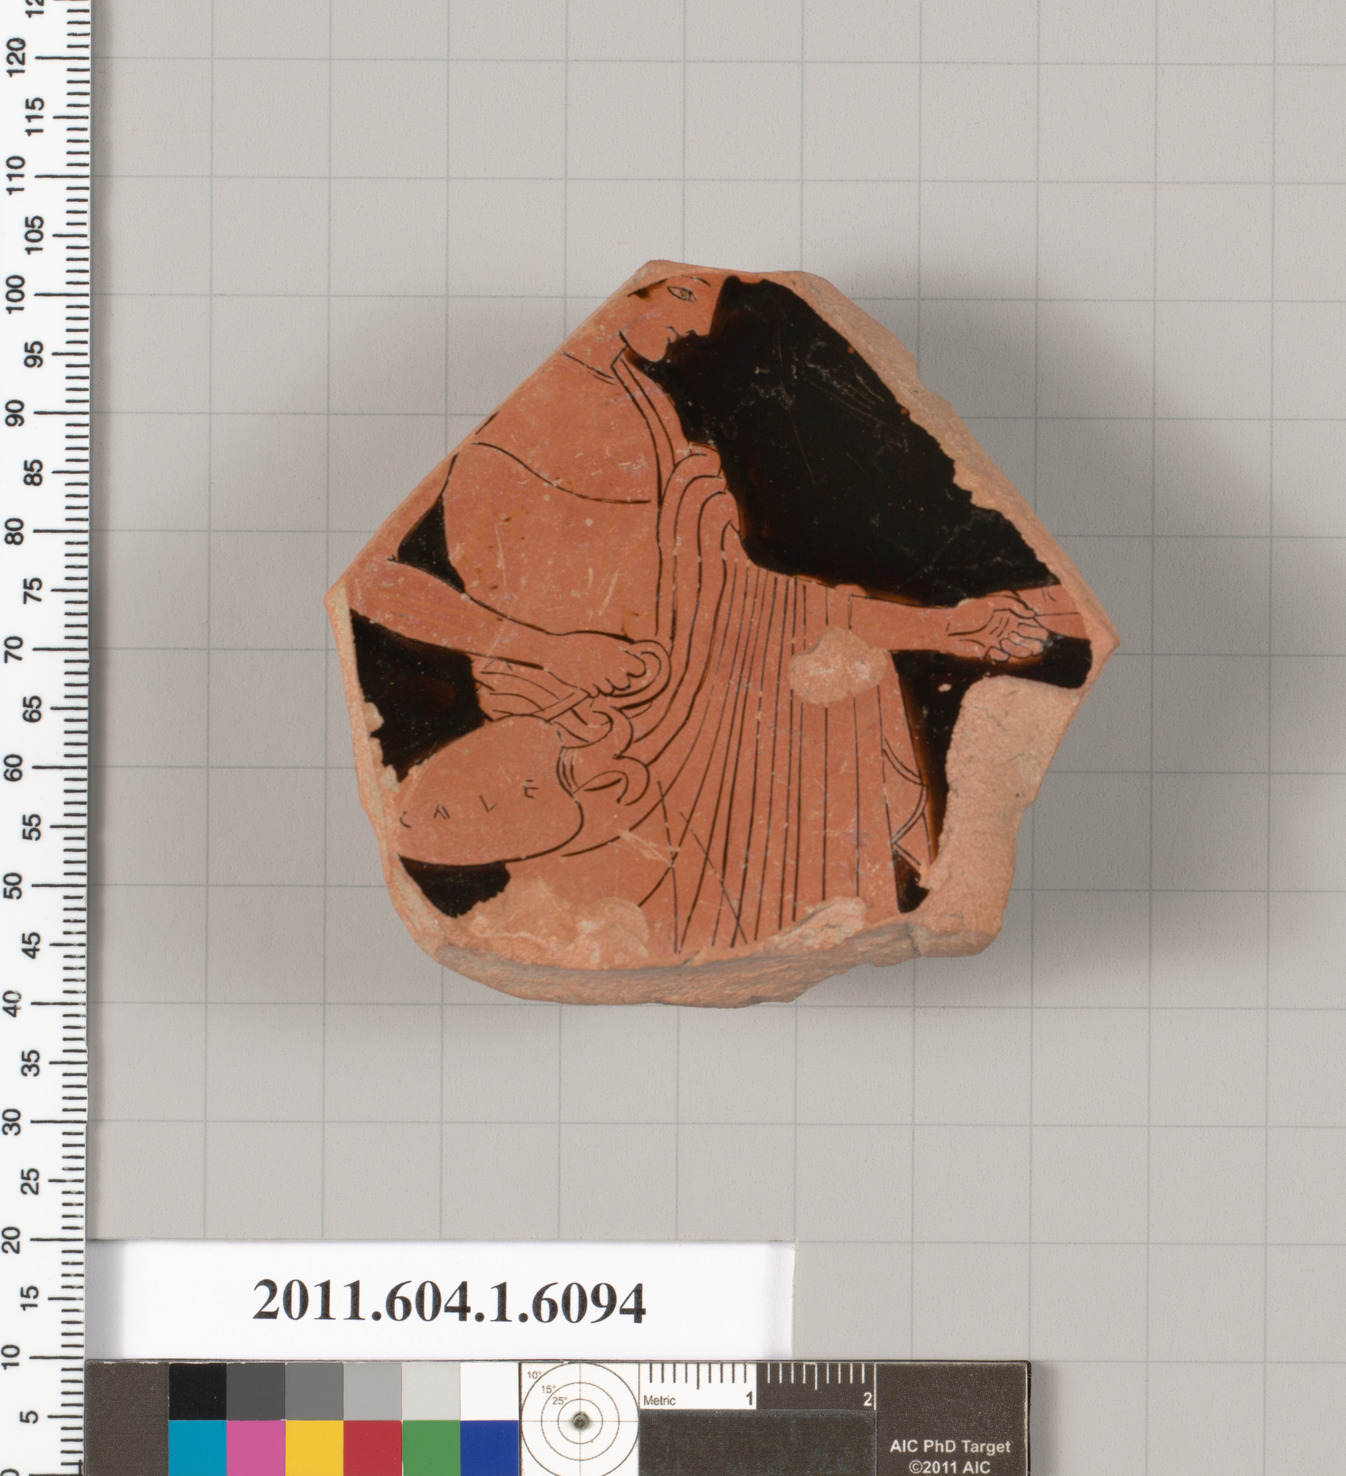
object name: kylix fragment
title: Terracotta fragment of a kylix (drinking cup)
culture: greek, attic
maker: apollodoros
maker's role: artist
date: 500-490 BCE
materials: terracotta